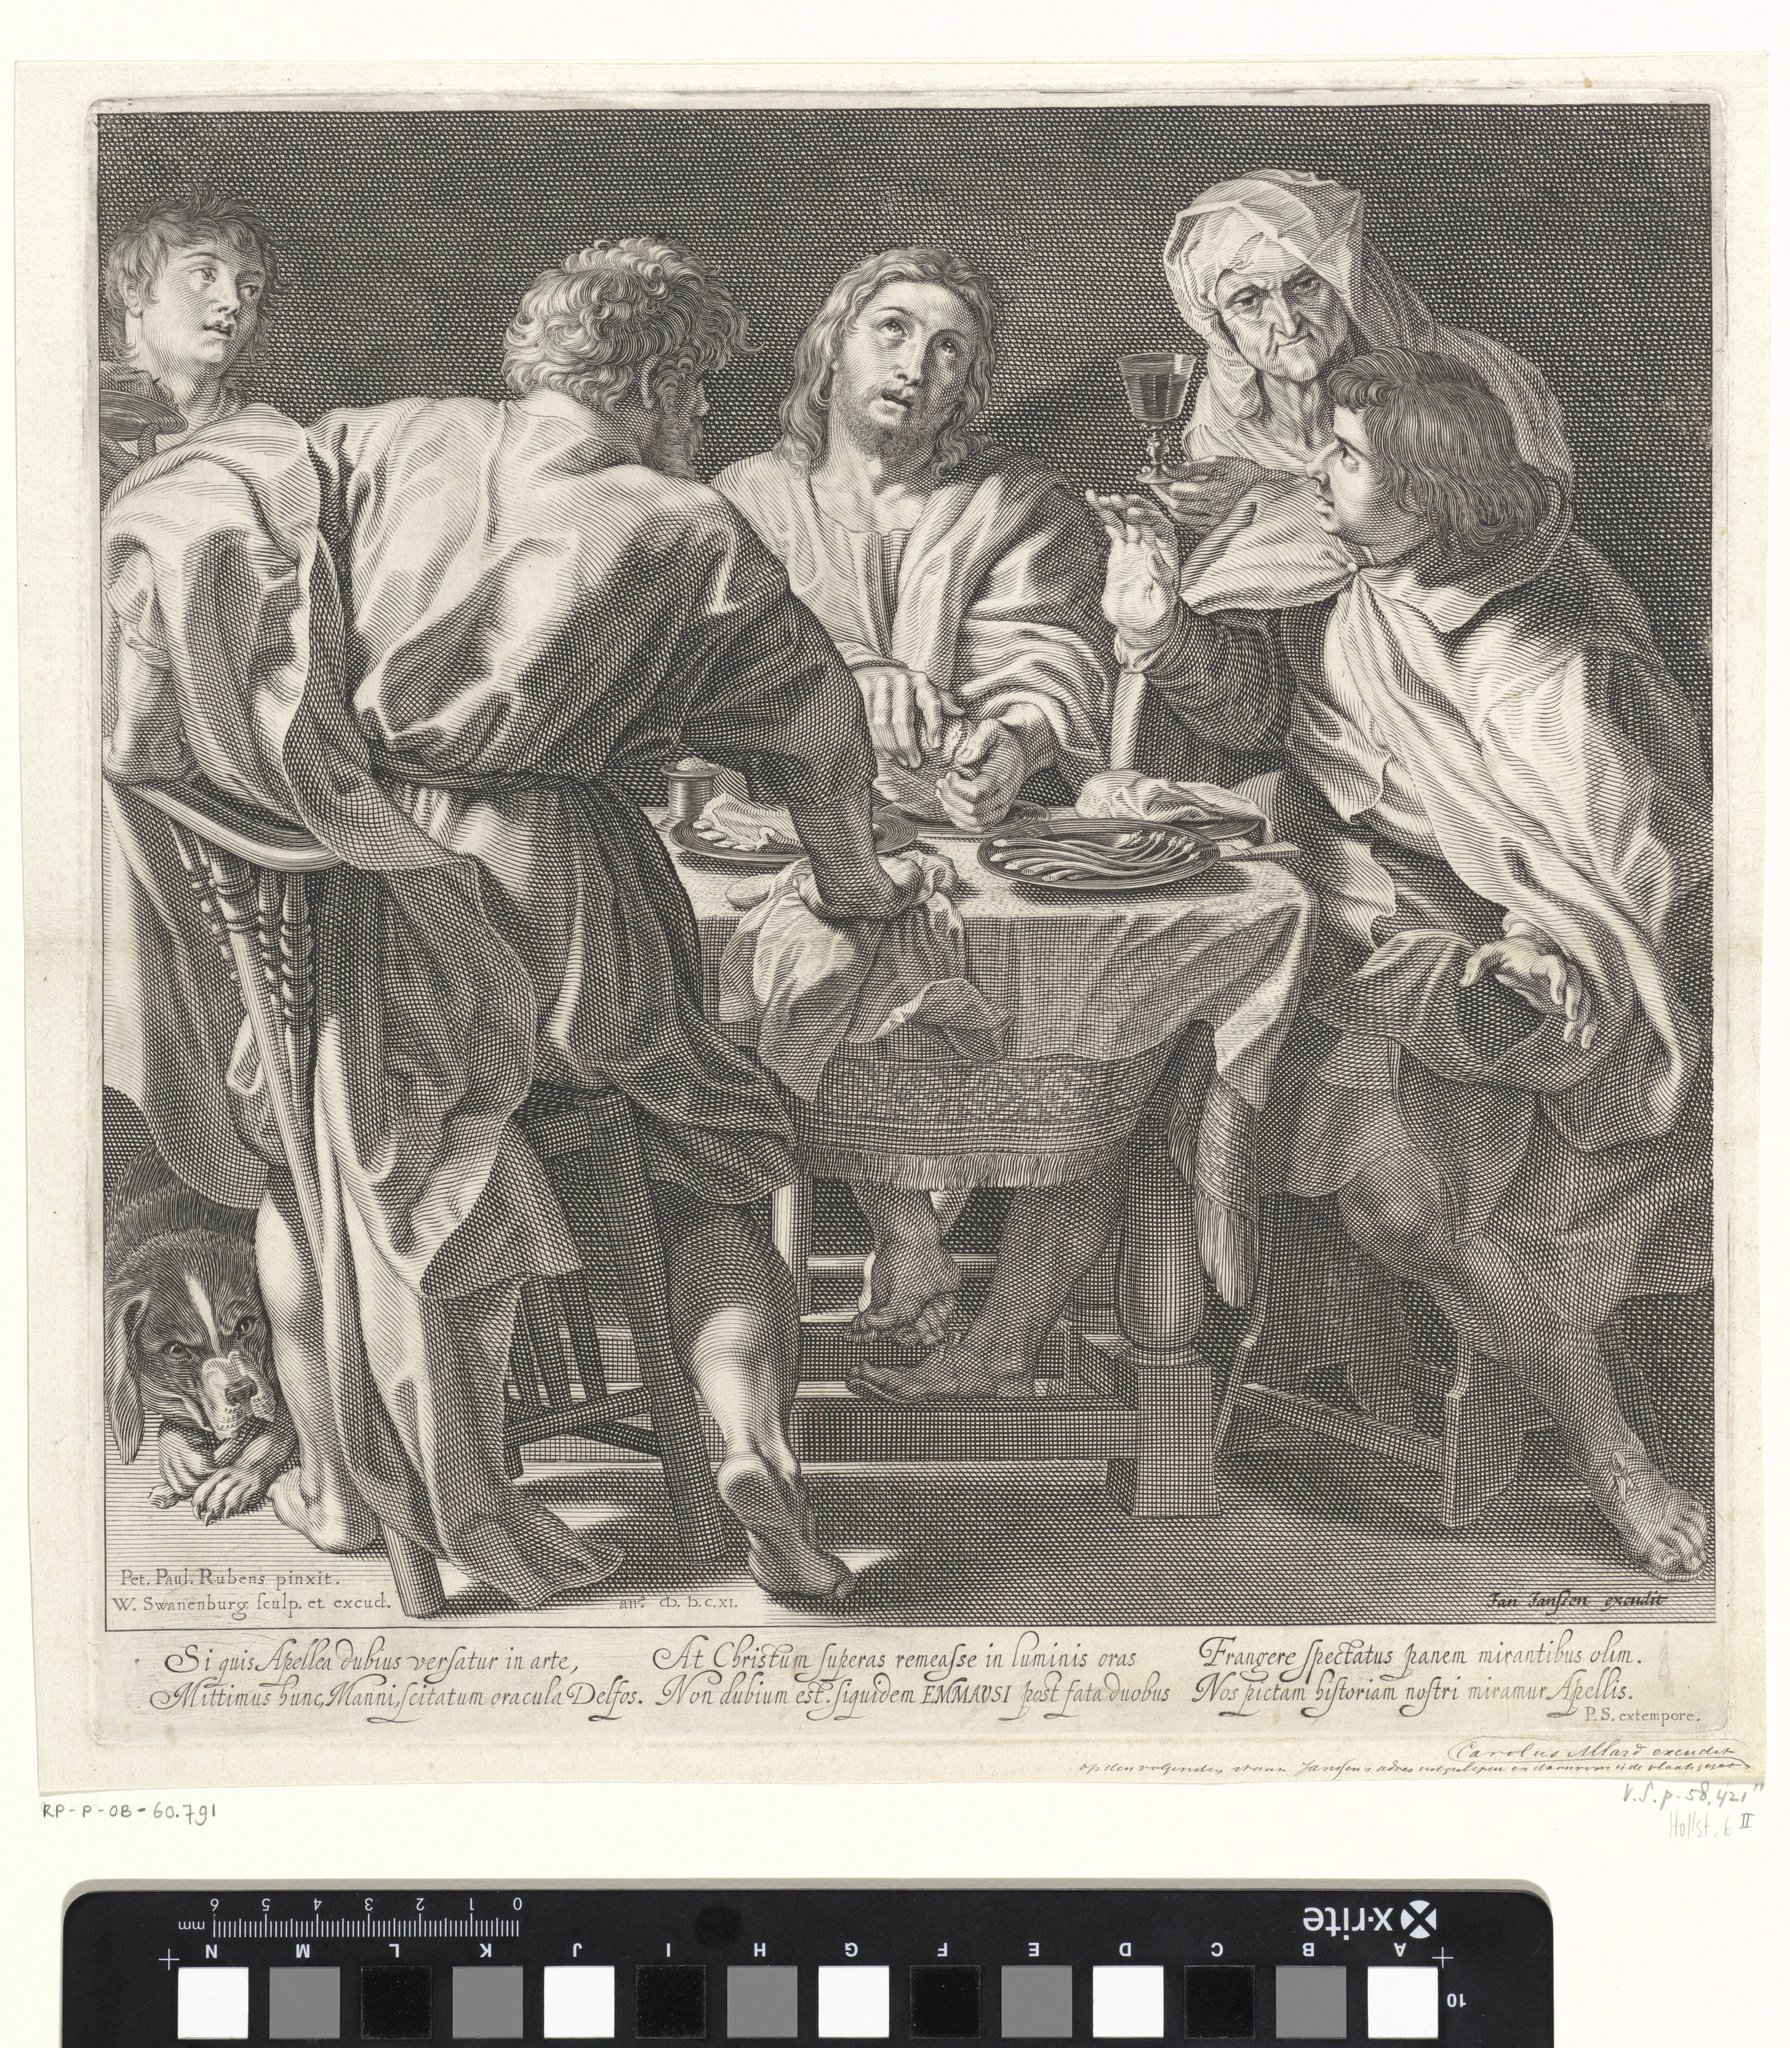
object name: print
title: Maaltijd in Emmaüs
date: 1611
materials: paper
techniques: engraving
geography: amsterdam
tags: (family) meal (+ serving, servants at table, meal), the supper at emmaus: christ is recognized while blessing or breaking the bread, glass of wine, dog, vegetables (with name)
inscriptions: collector's mark: Lugt 2228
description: Christus zit met zijn leerlingen aan tafel. Hij zegent en breekt het brood, waardoor zijn leerlingen hem herkennen. Rechts geeft een vrouw een glas wijn aan en onder de tafel ligt een hond. Onder de voorstelling bevindt zich een zesregelige, Latijnse tekst met een beschrijving van de scène en een lofdicht op Rubens, waarin hij met Apelles wordt vergeleken.